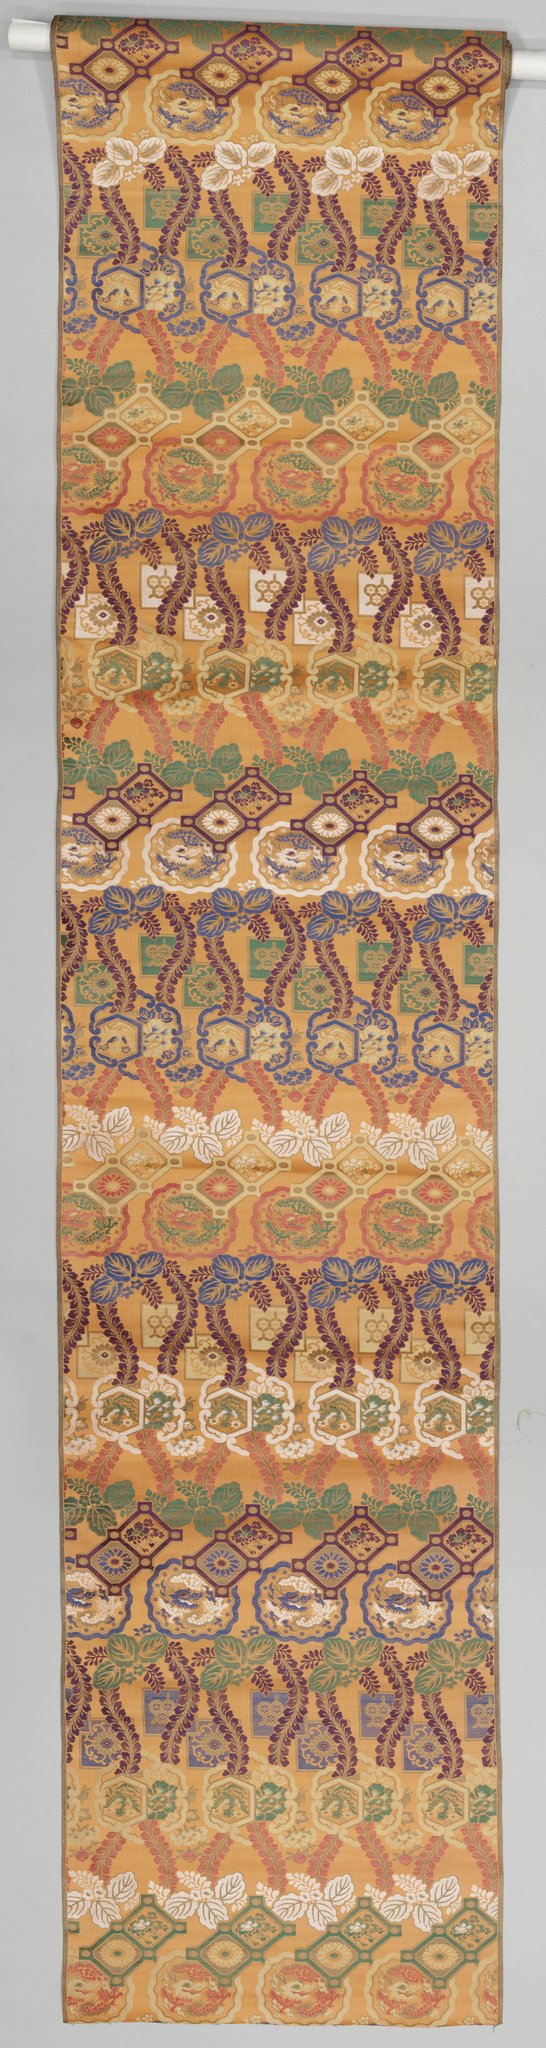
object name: textile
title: Baan zijdedamast met een dessin van banen met bladwerk, geschakelde zeshoeken gevuld met bloemen, gelobde rechthoek gevuld met vogels en draken en dergelijke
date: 1900-1920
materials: silk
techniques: damask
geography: japan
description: Baan zijdedamast met een relatief groot dessin van banen met bladwerk, twee geschakelde zeshoeken gevuld met bloemen, gelobde rechhoek gevuld met vogels en draken, bladeren, omhoogrijzende bladranken, vierkanten gevuld met geschakelde achthoeken en een (lotus)bloem, een zespas gevuld met een bloem en een zeshoek, op zijn beurt gevuld met een vogel, omhoog rijzende bladranken. Dit alles in roze, groen, rood, blauw, wit, zilvergrijs, paars en écru op een oranje fond. Oosterse textiel.